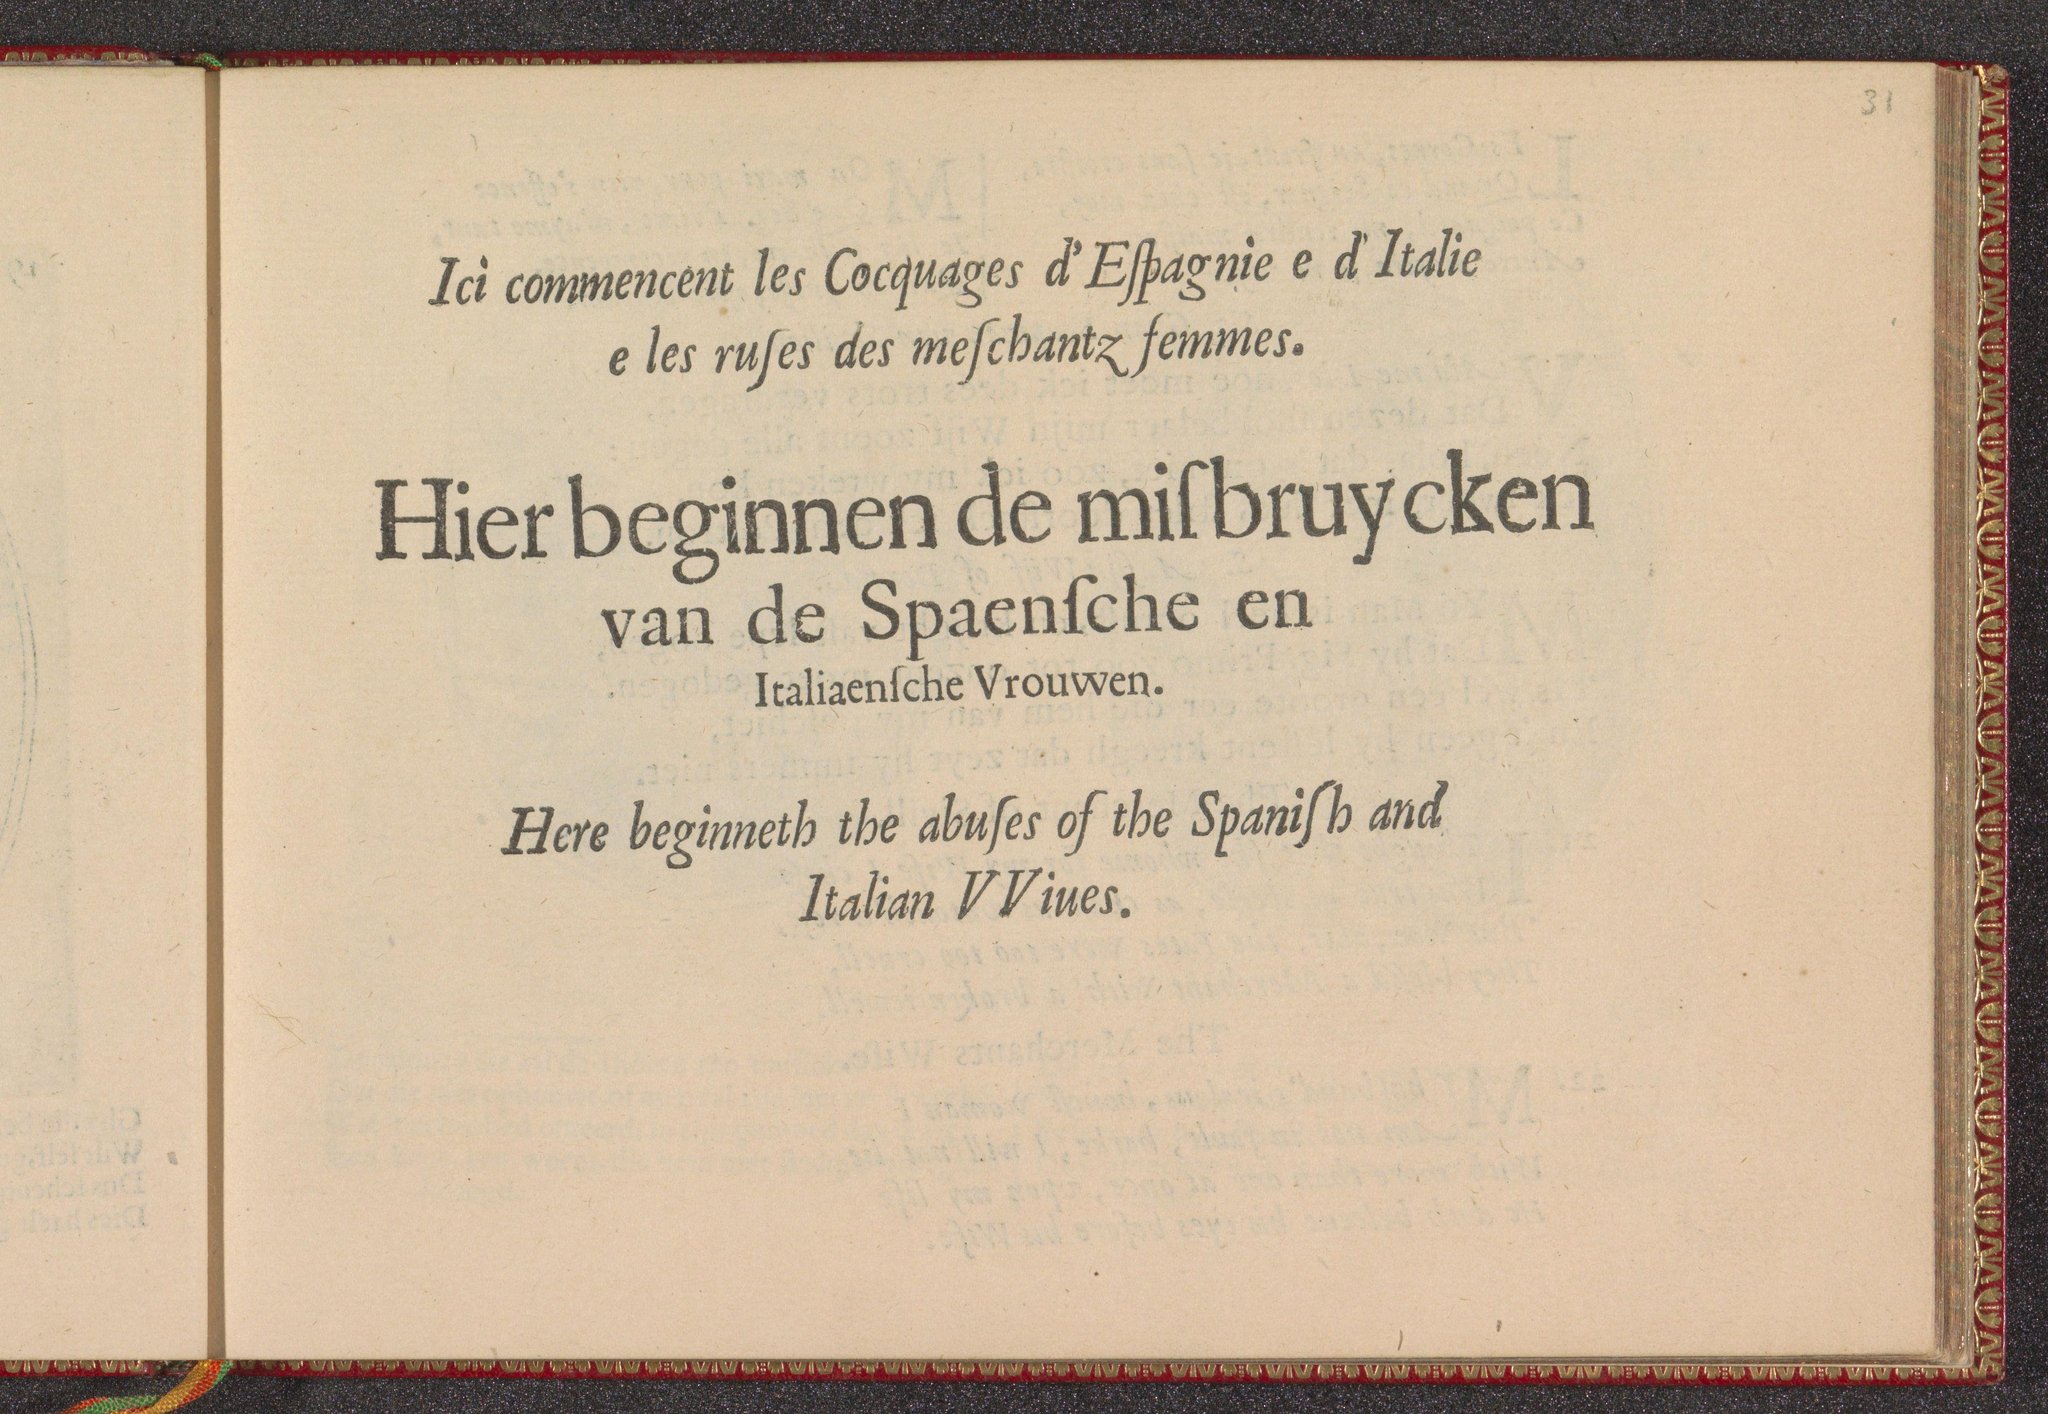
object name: text sheet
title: Les abus du mariage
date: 1641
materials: paper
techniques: letterpress printing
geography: amsterdam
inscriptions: date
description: Titel voor het tweede deel van de serie: Les abus du mariage ... Het blad maakt deel uit van een album.